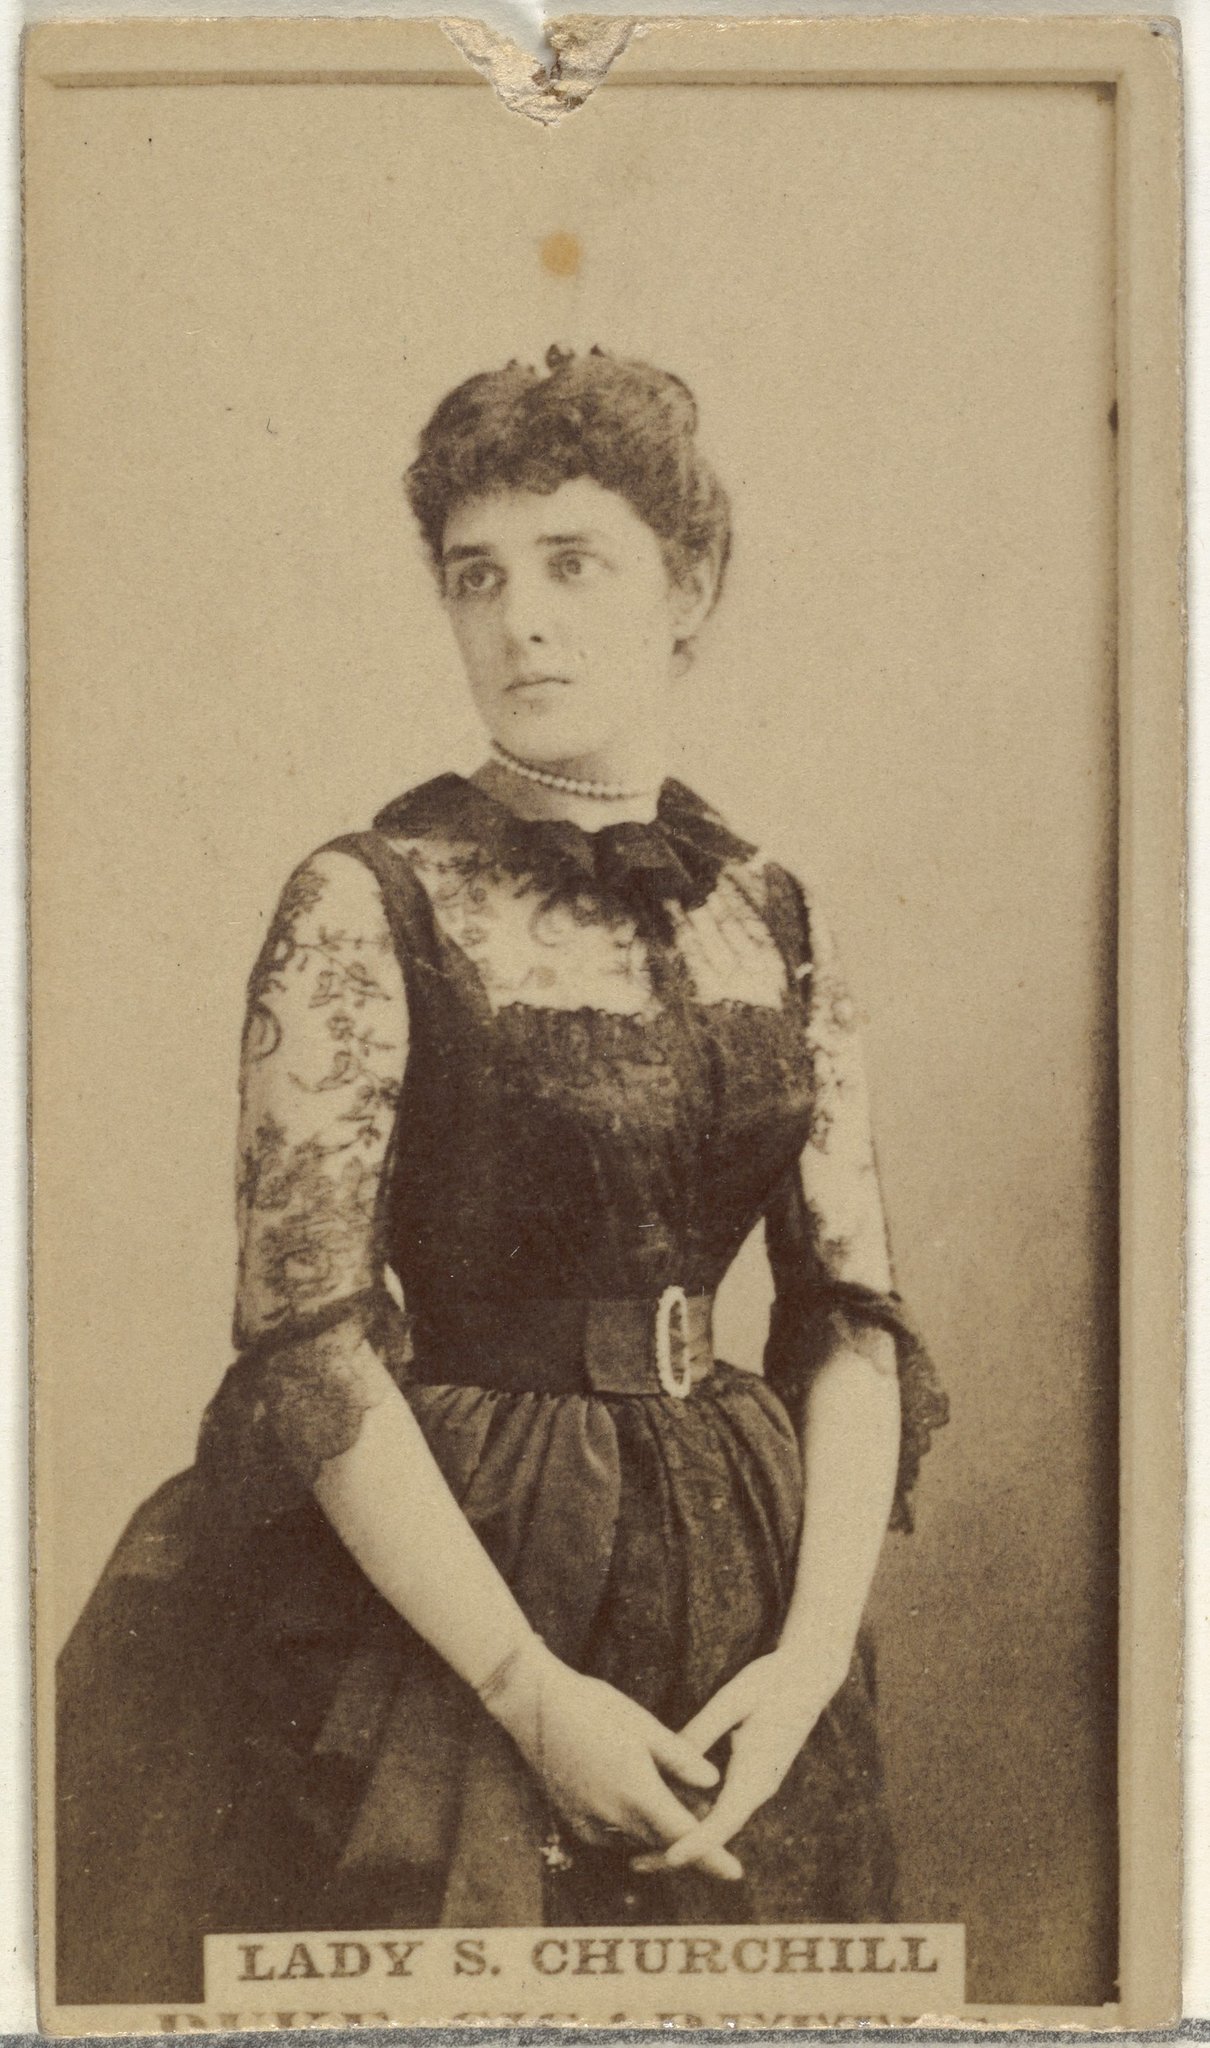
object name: photograph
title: Lady S. Churchill, from the Actors and Actresses series (N145-7) issued by Duke Sons & Co. to promote Duke Cigarettes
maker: w. duke, sons & co.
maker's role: publisher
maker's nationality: american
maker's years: 1870-1920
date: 1880-1889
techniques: albumen silver print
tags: portraits,women,actresses